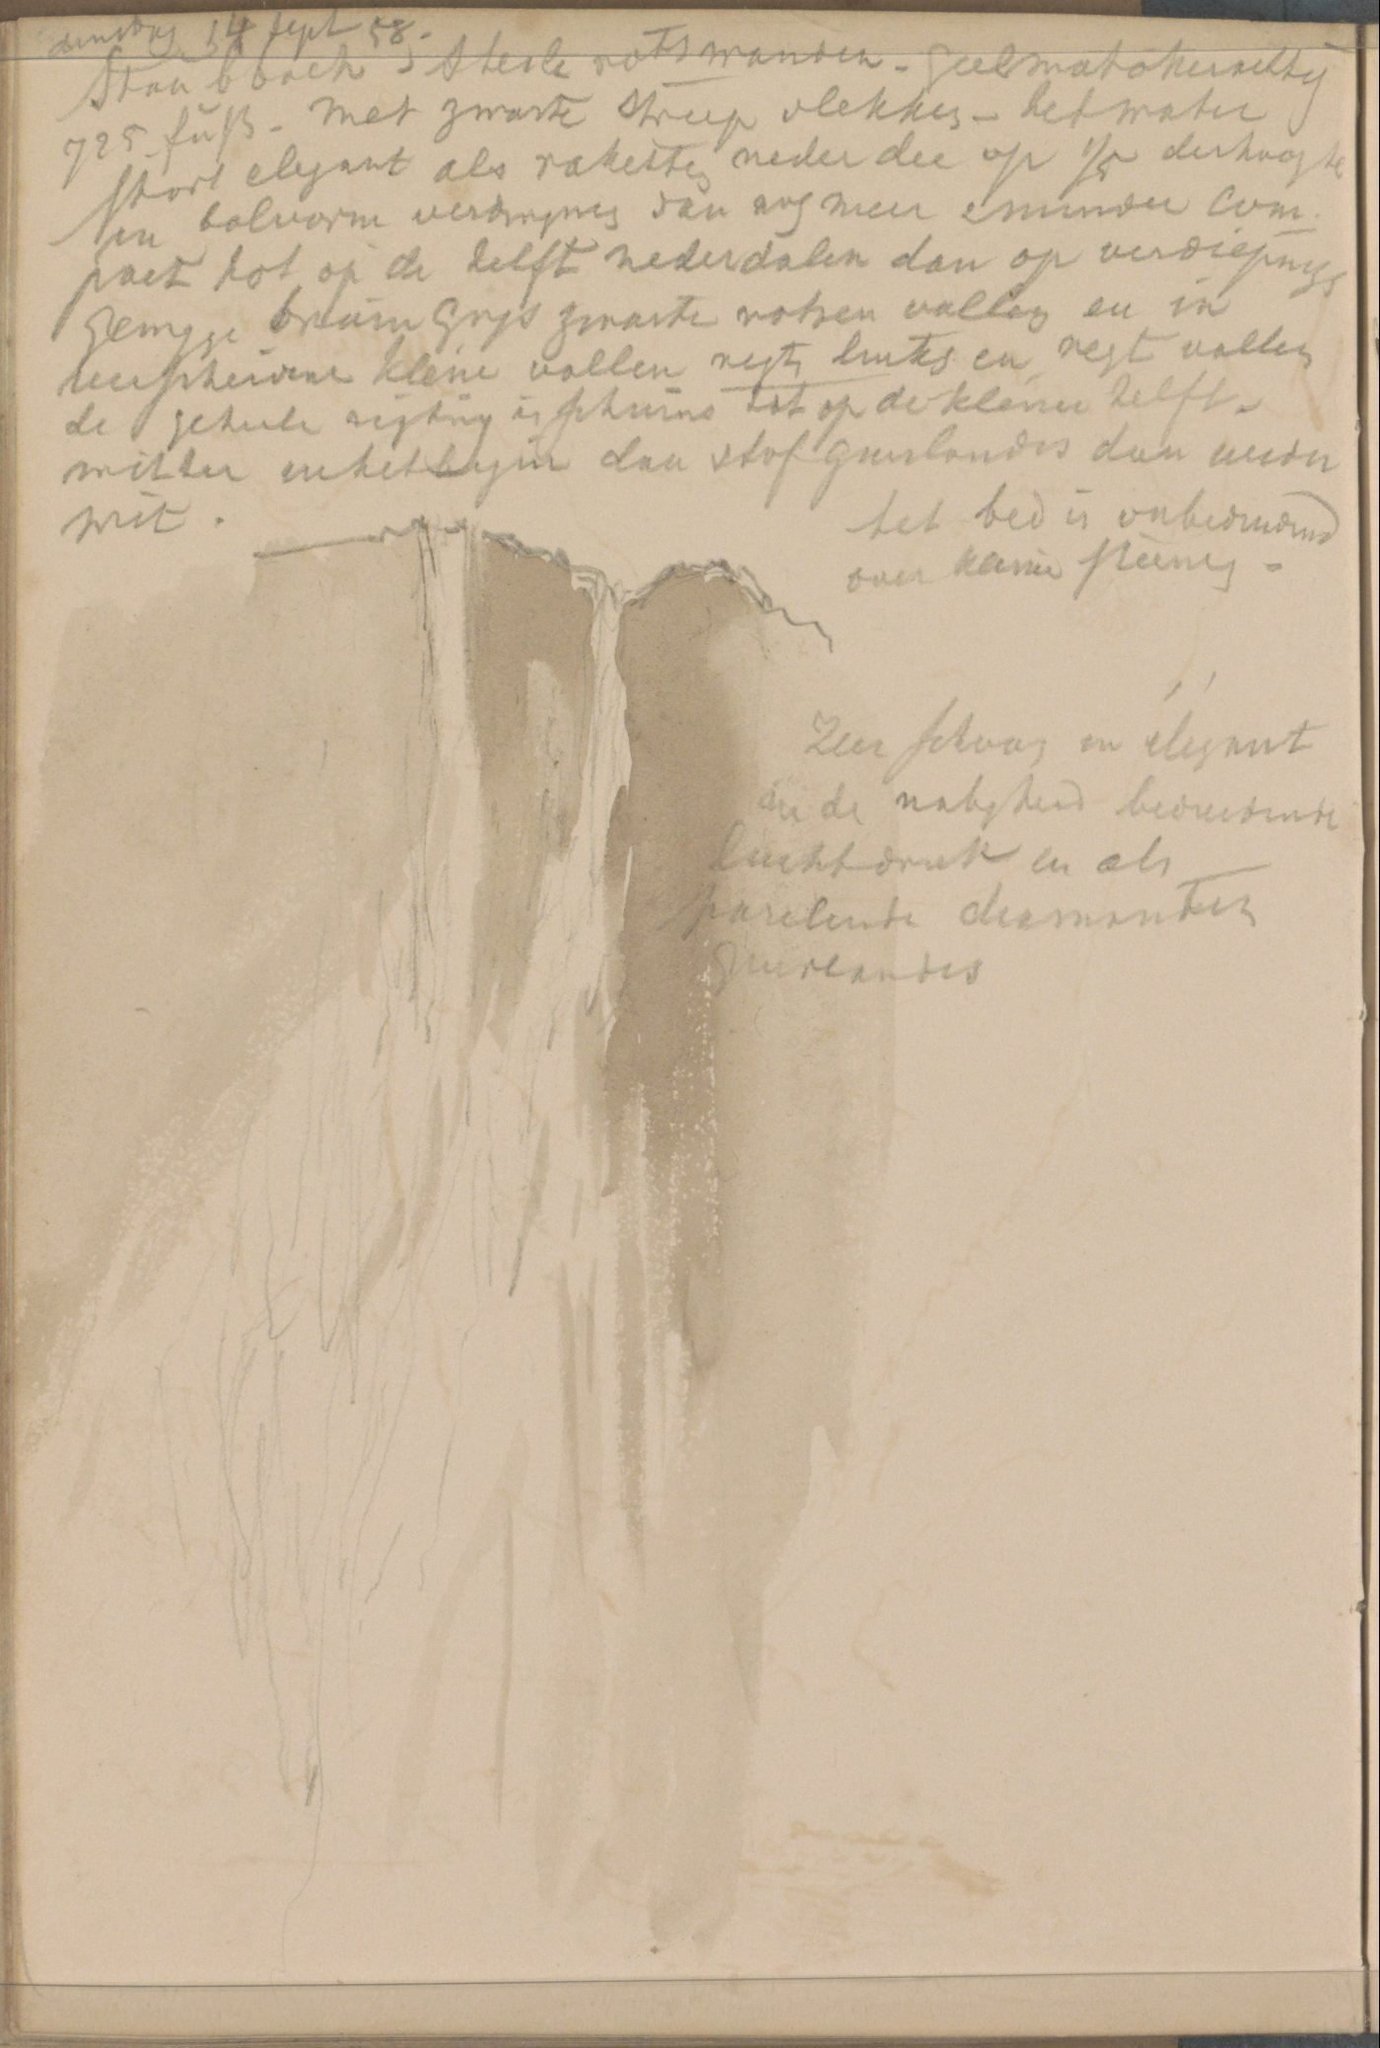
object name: sketchbook leaf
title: Rots met een waterval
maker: johannes tavenraat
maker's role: draughtsman, painter, print maker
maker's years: 1809-1881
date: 1809-1858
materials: ink, paper, pencil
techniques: brush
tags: waterfall, rocks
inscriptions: date and inscription: ‘14 Sept 58’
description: Blad 33 verso uit een schetsboek met 47 bladen.